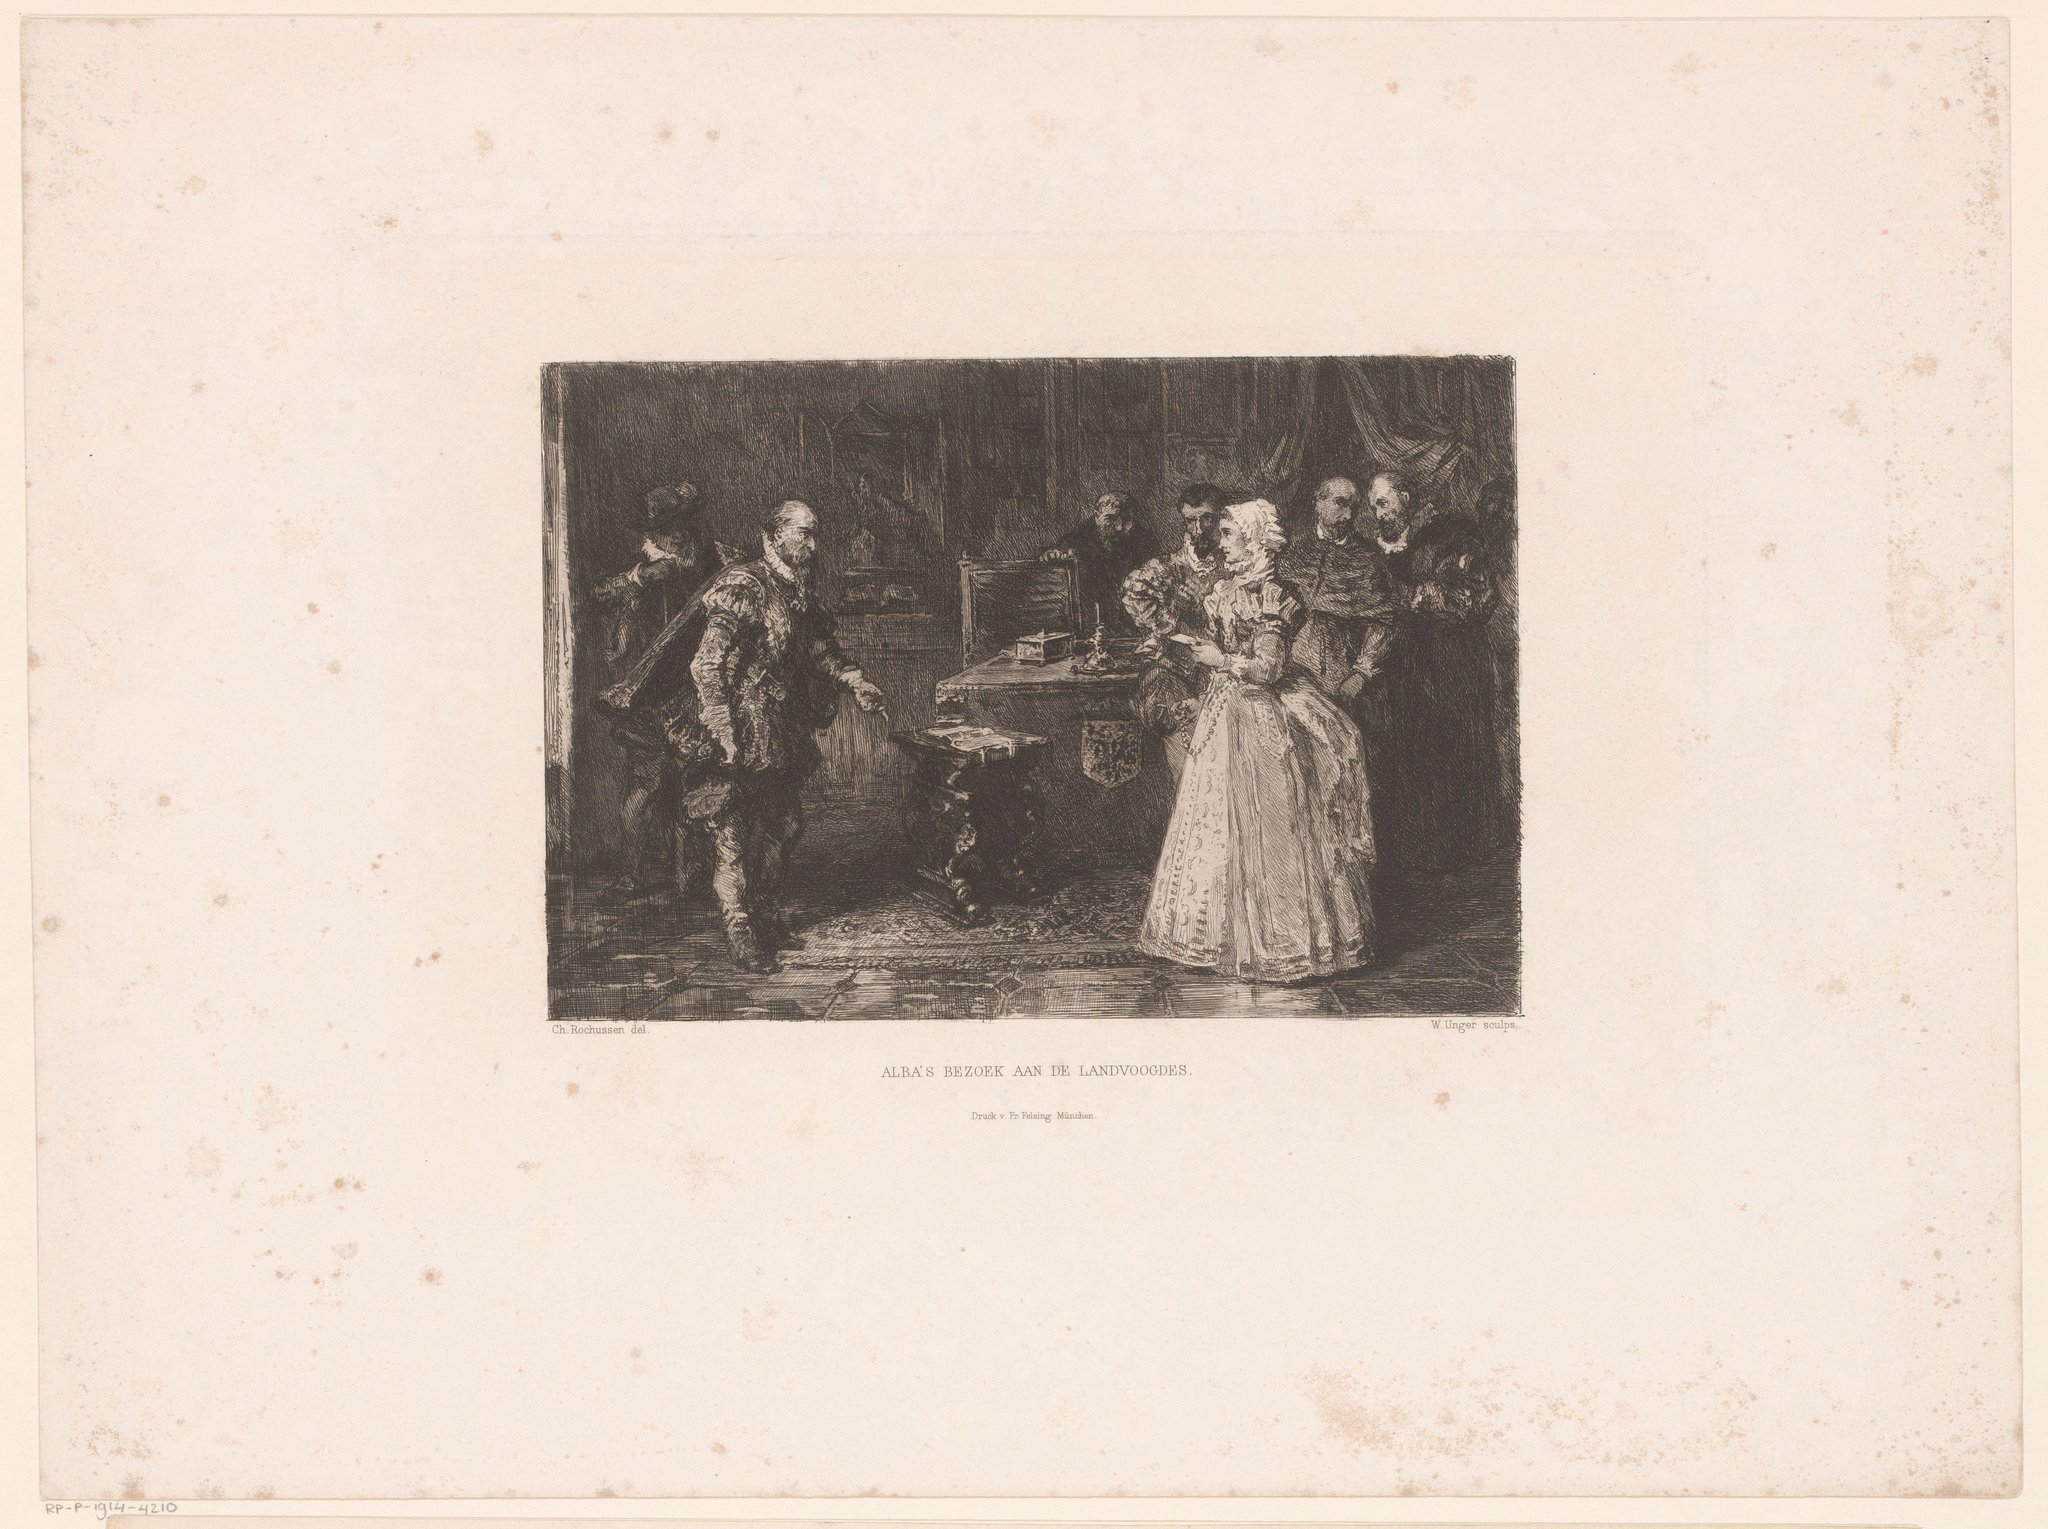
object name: print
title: Alba's bezoek aan de Landvoogdes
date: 1871-1873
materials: paper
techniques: etching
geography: germany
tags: fernando álvarez de toledo (3rd duke of alba), brussels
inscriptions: collector's mark: Lugt 2228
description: Gebruikt als illustratie in: In memoriam. Tafereelen uit Hollands tachtig-jarigen strijd. Met etsen van William Unger naar teekeningen van Ch. Rochussen en Herman ten Kate. Haarlem: A.C. Kruseman, 1873. Verschenen in 10 afleveringen met tekst en afbeelding, nr. 3.